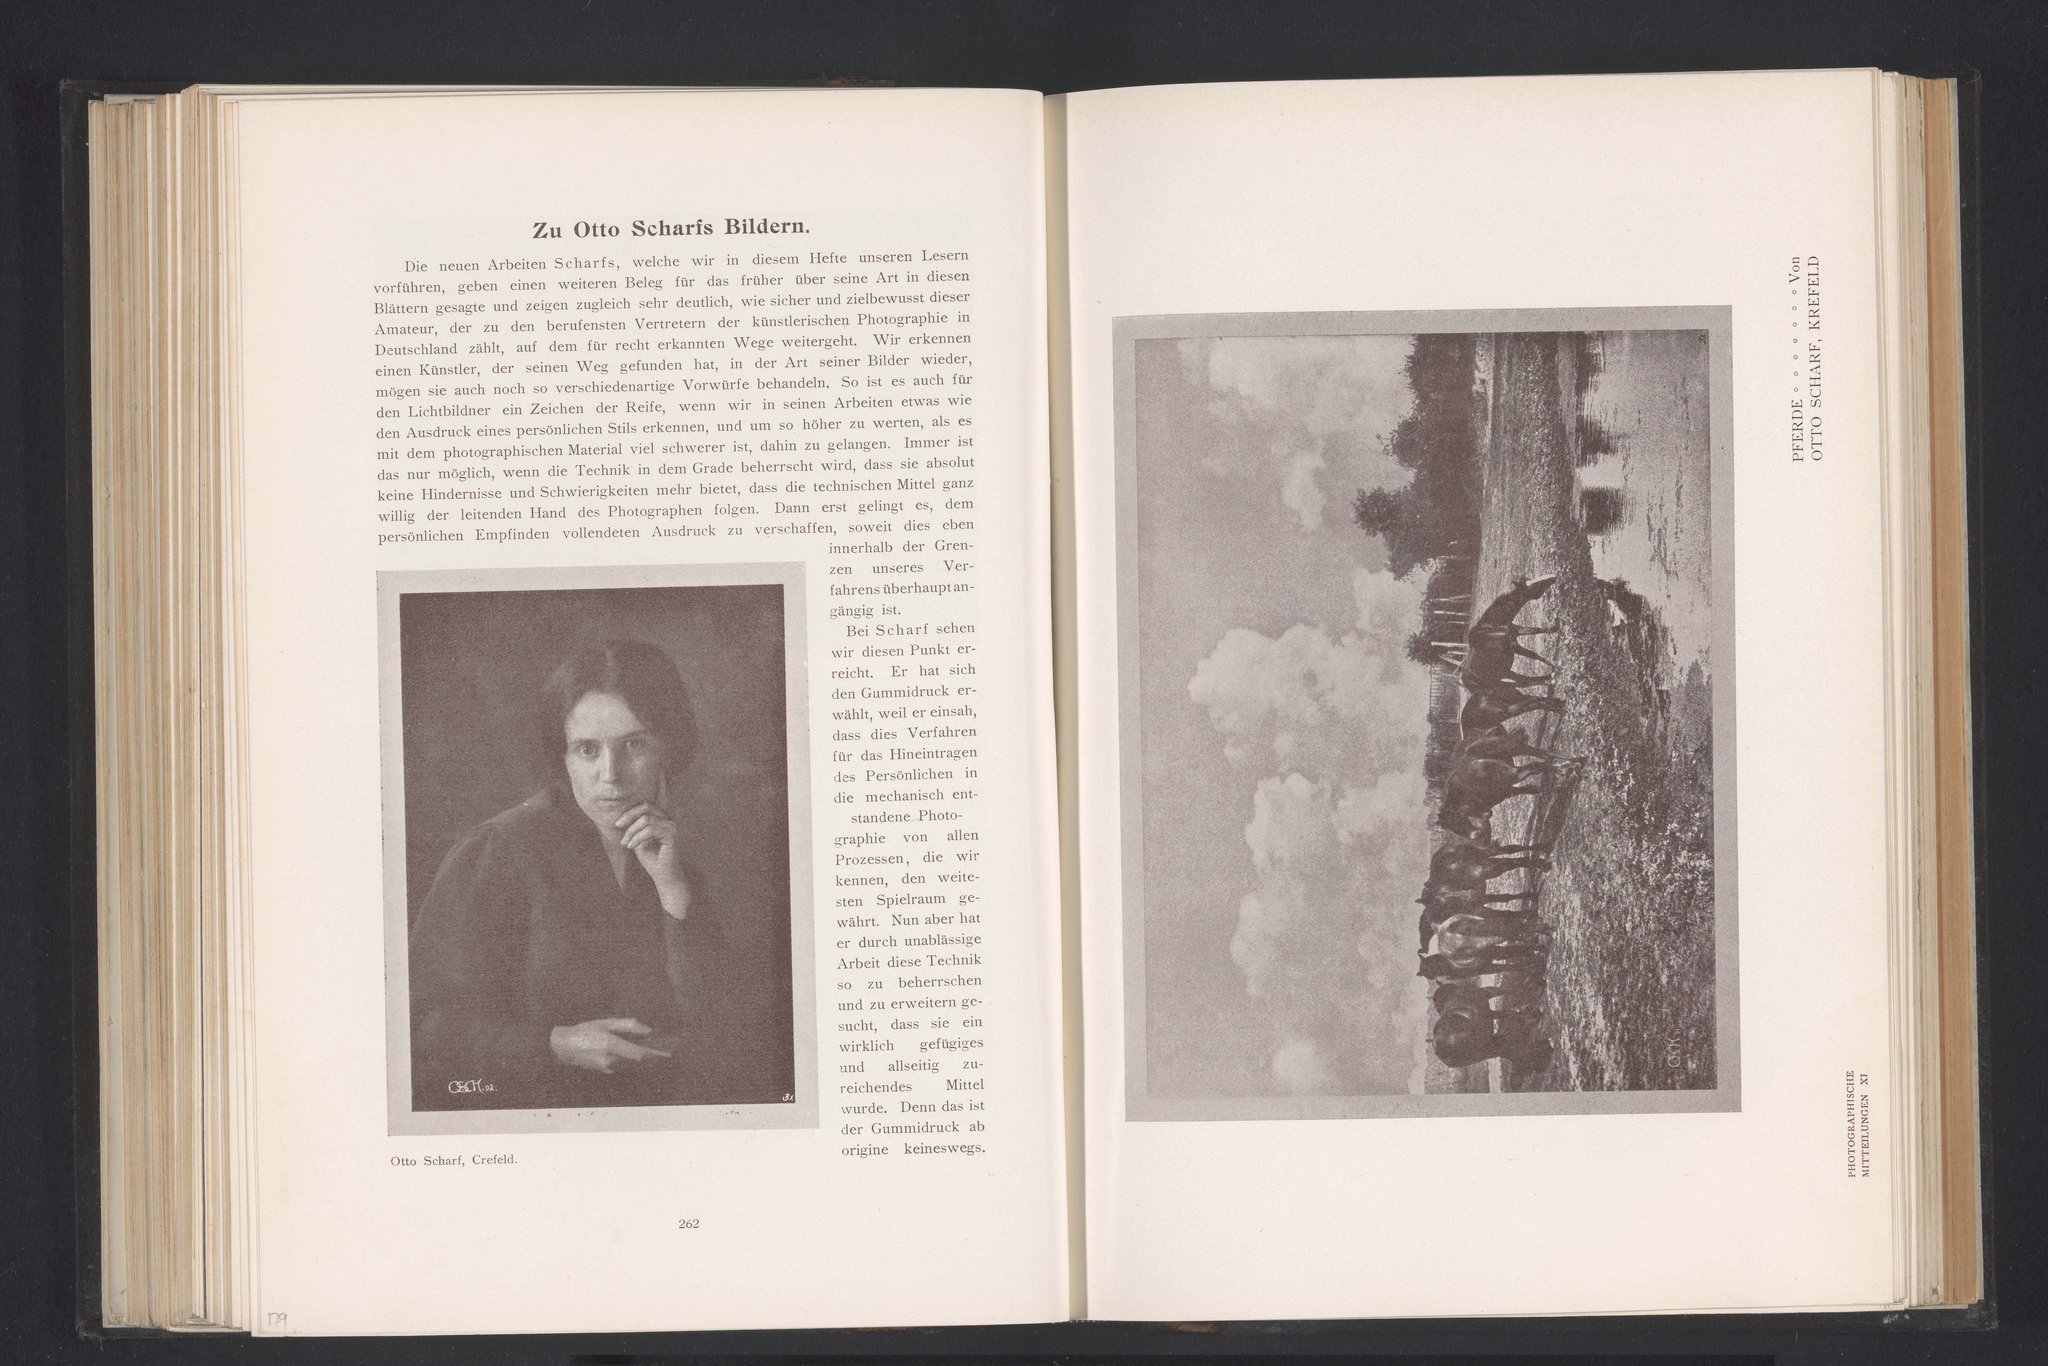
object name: photomechanical print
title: Paarden in de wei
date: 1898-1903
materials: paper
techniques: autotype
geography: krefeld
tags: meadow, pasture, horse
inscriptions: monogram: ‘BX’